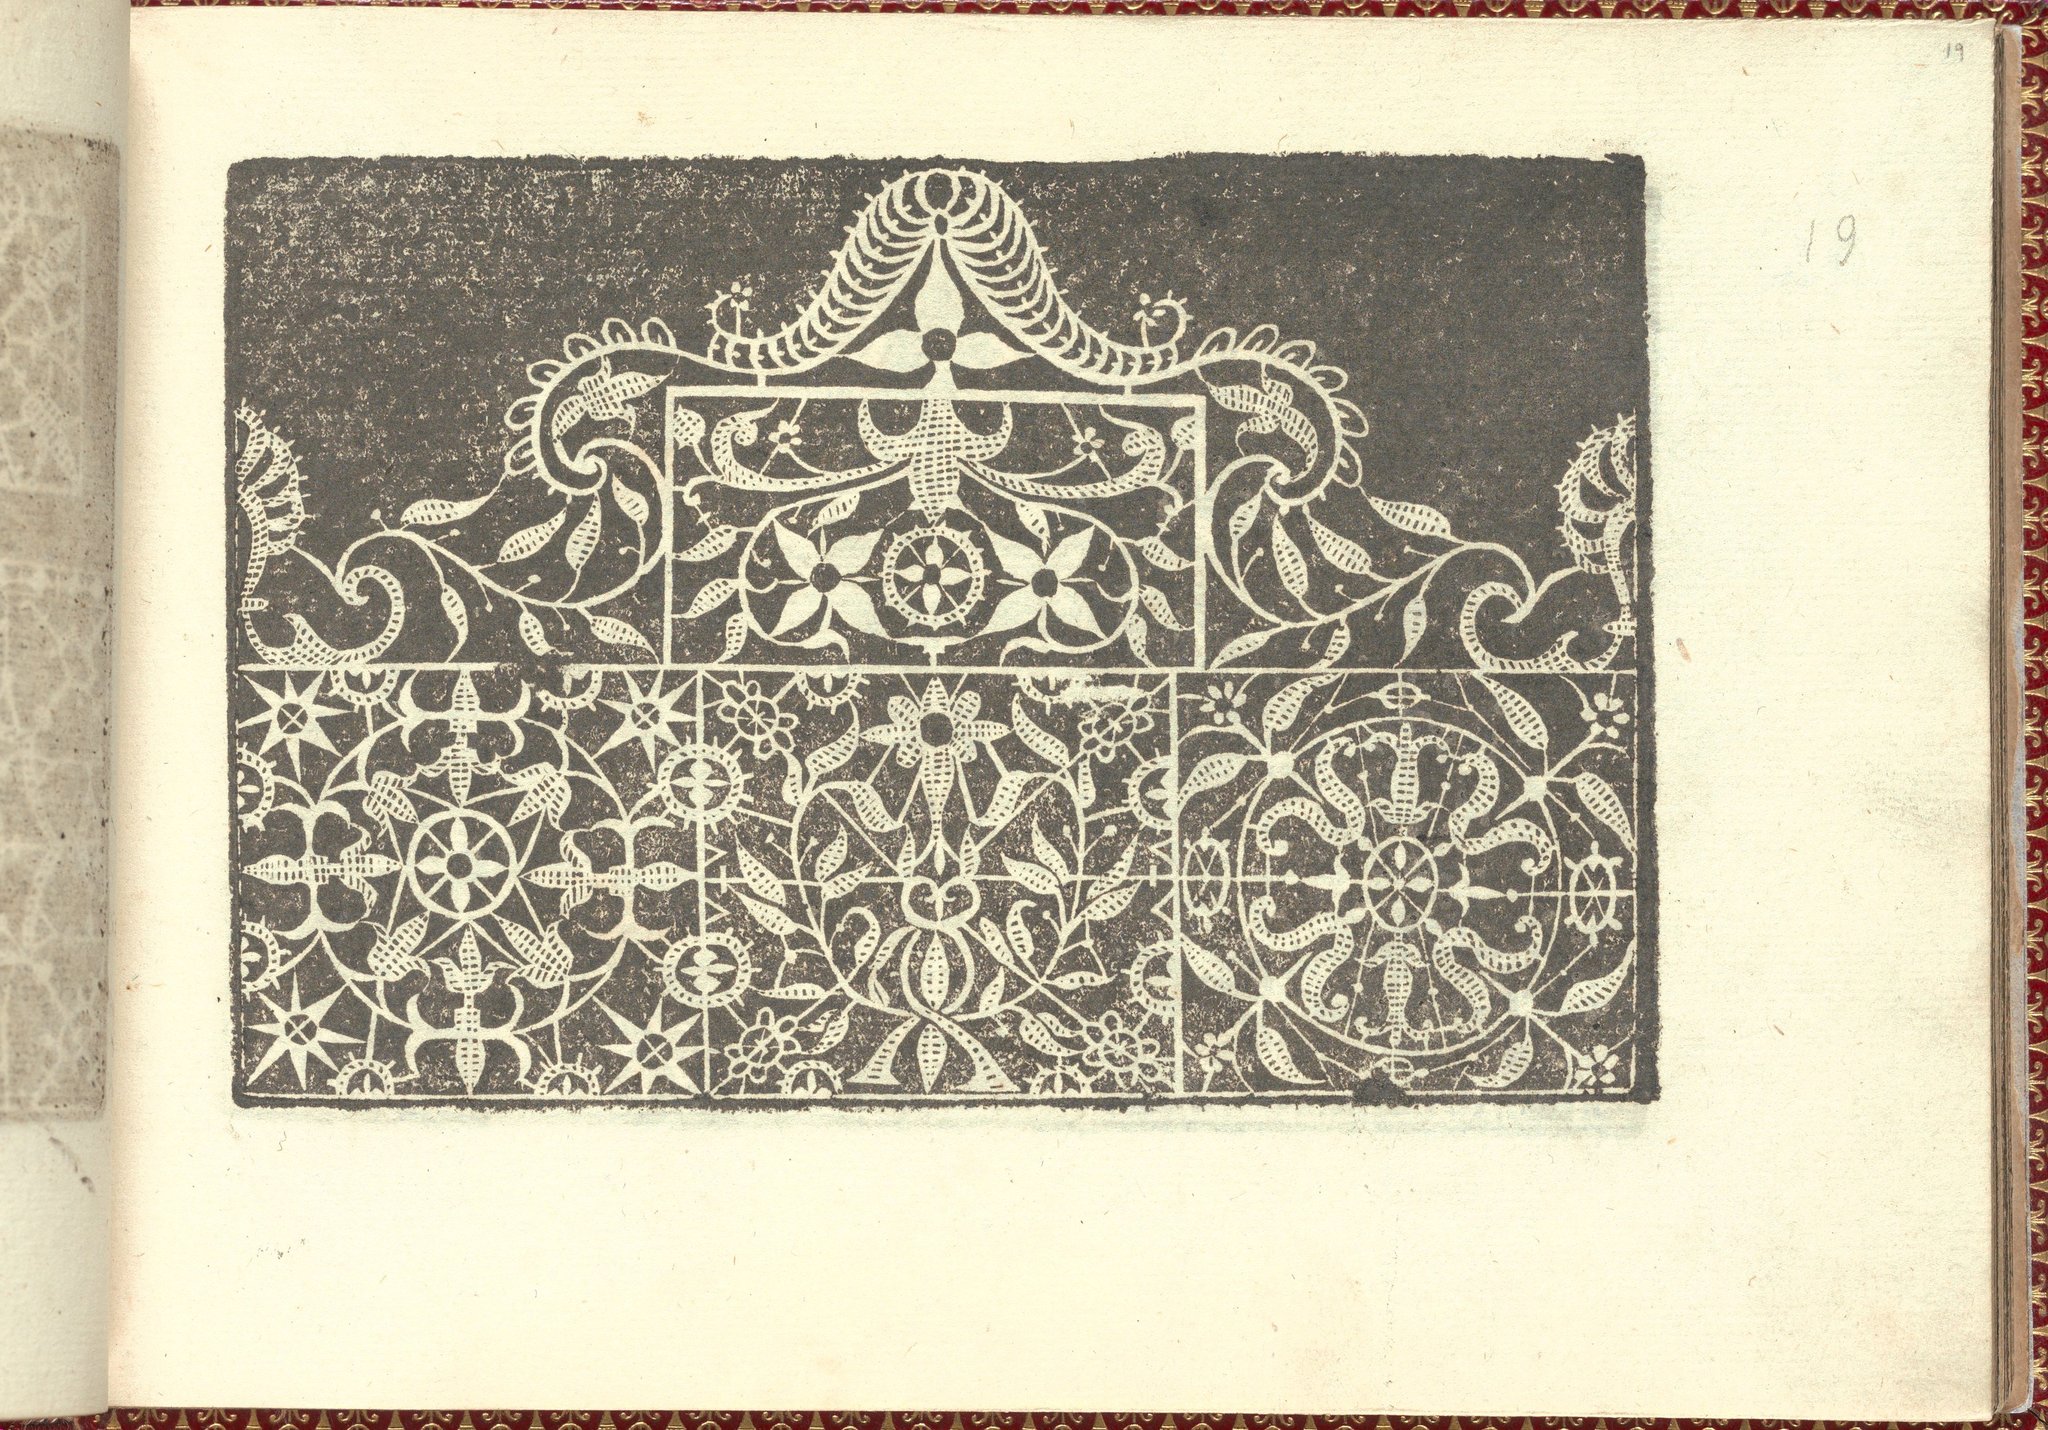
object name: book print ornament architecture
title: Corona delle Nobili et Virtuose Donne: Libro I-IV, page 19 (recto)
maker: cesare vecellio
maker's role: publisher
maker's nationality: italian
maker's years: 1521-1601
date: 1601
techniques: woodcut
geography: italy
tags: ornament